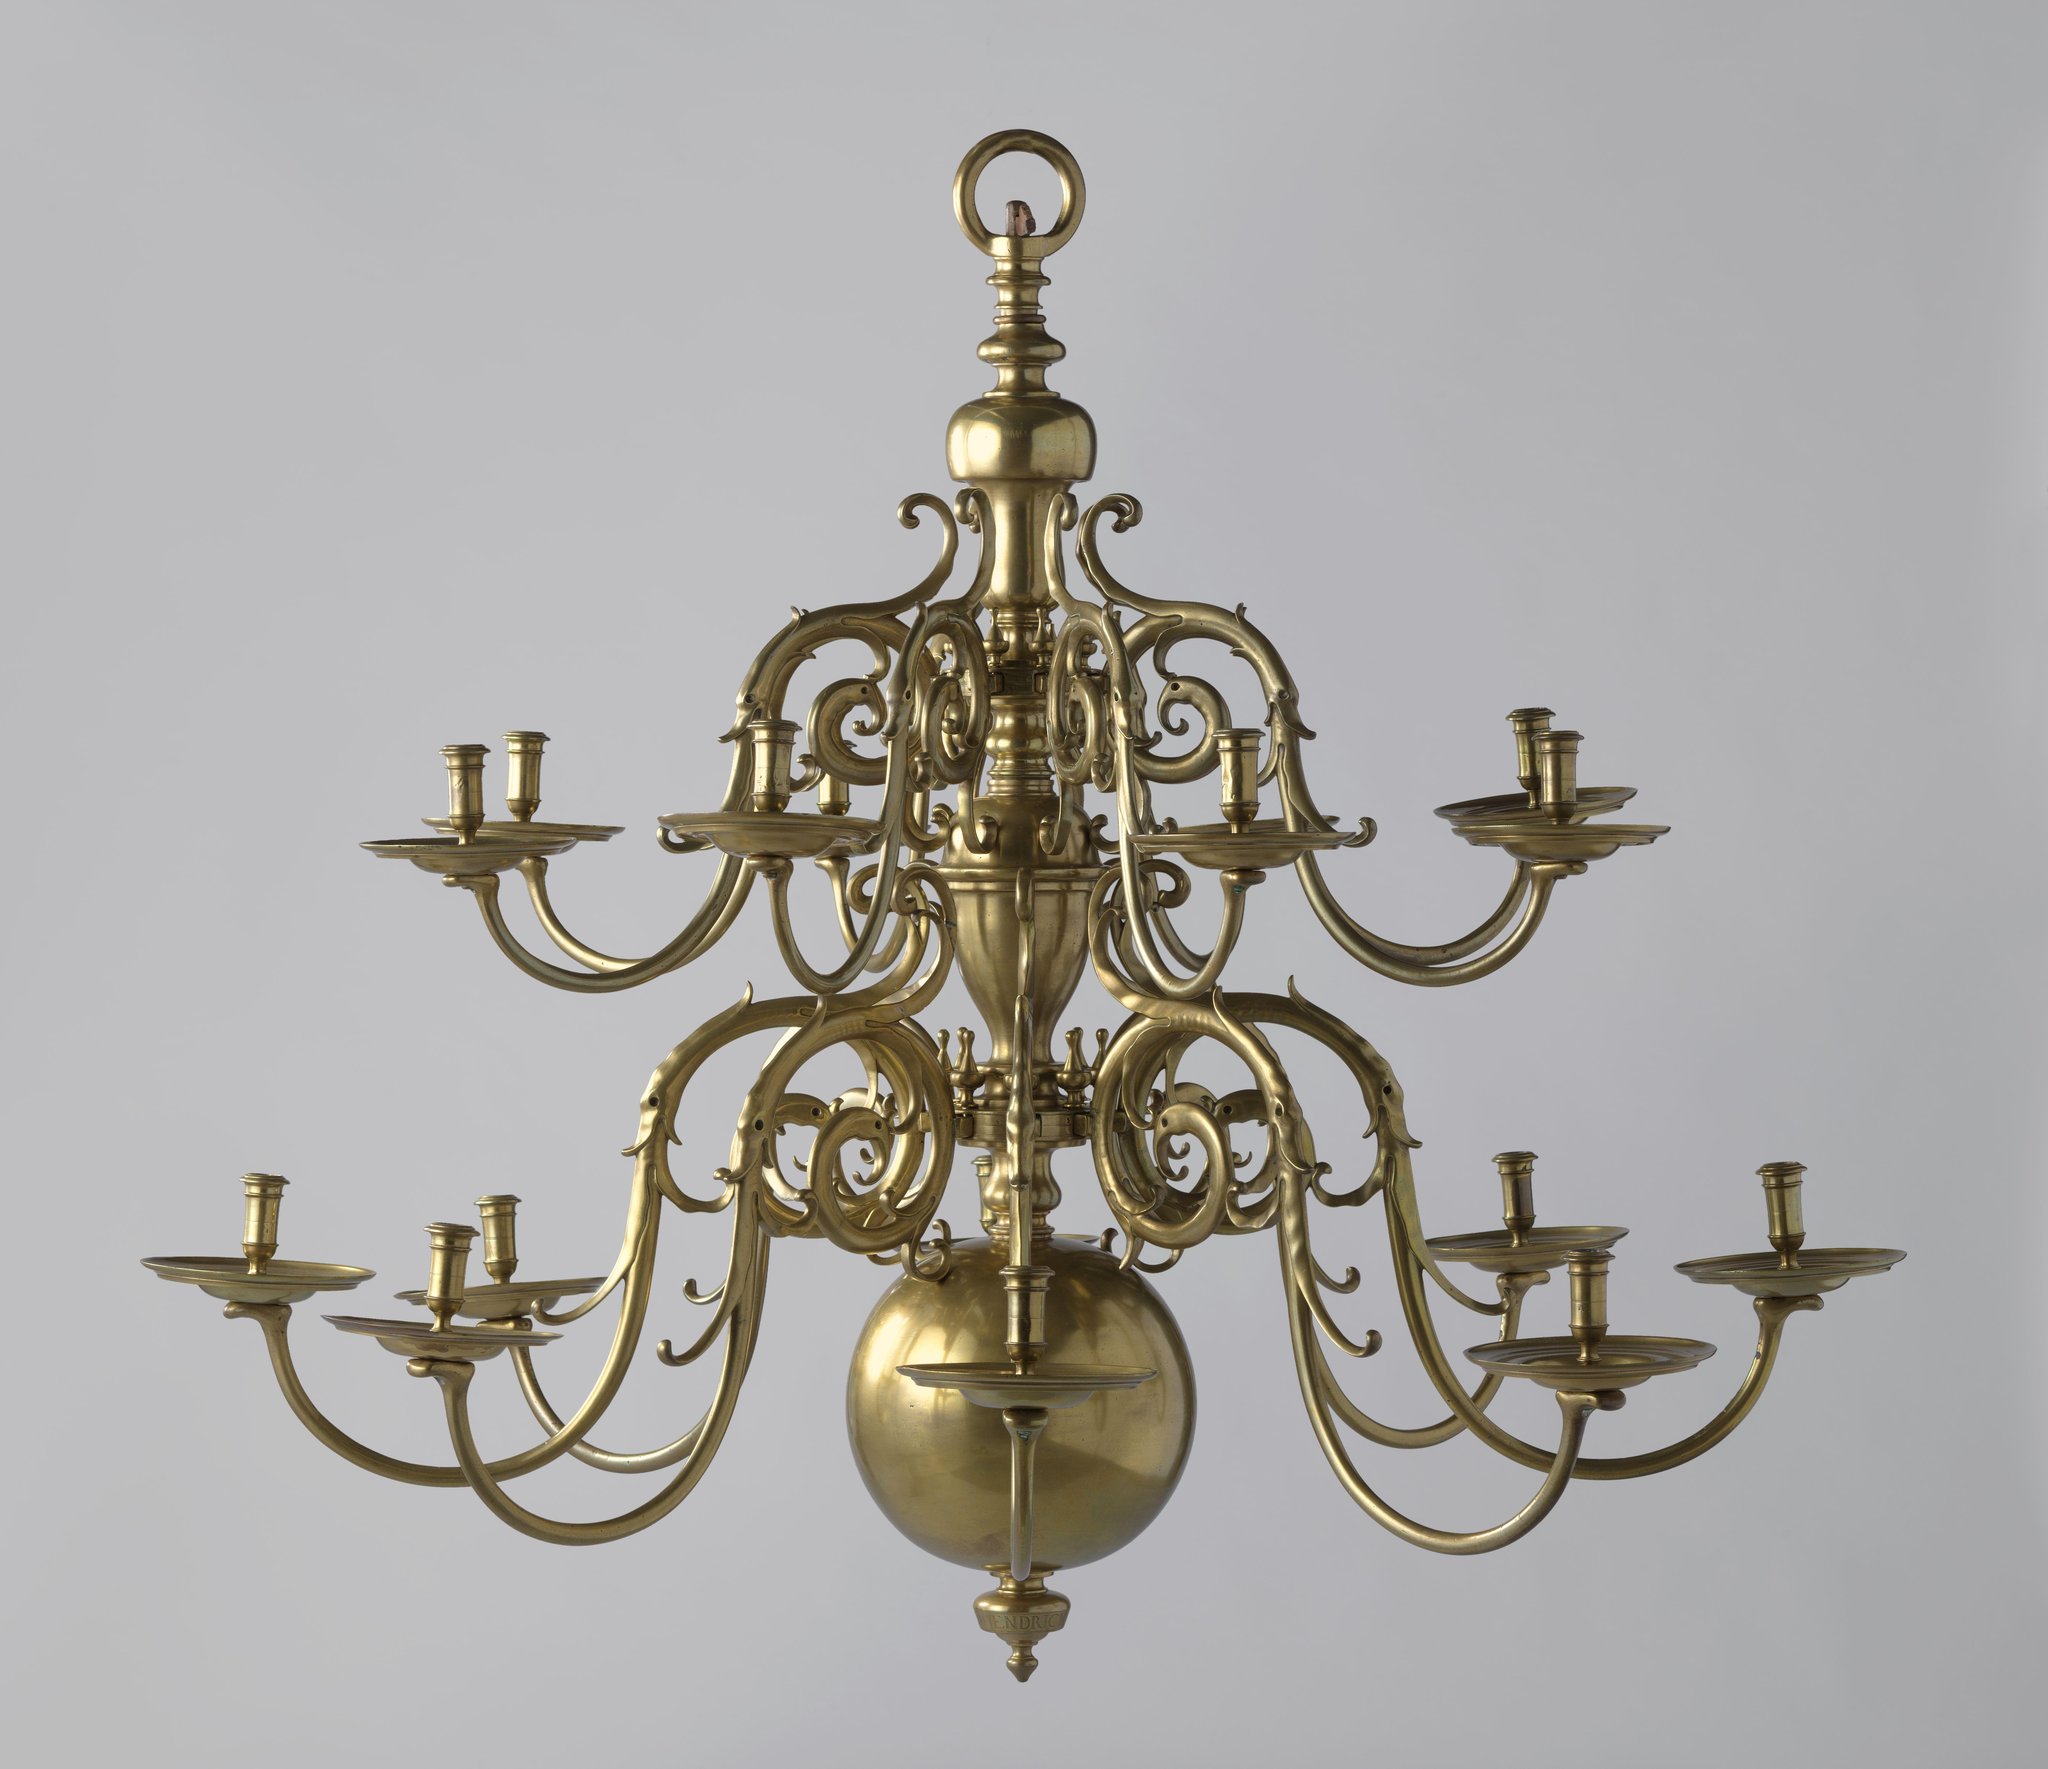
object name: chandelier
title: Arm met kaarsenhouder van kaarsenkroon van twee hoogten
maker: Anonymous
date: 1650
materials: brass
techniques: casting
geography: amsterdam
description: Kaarsenarm behorende bij een messing kaarsenkroon van twee hoogten. De S-vormige arm heeft een krul bij de aanzet, halverwege een dolfijnenkop en gaat naar buiten toe over in het platte verdikking met een schroefgat. Daarin is de kaarsenhouder met de vetvanger vastgezet. De vetvanger is aan de onderzijde geribd geprofileerd rond de opening en heeft een naar onder en een iets uitstekend randje. De cylindrische kaarsenhouder heeft een geprofileerde en een uitstekende rand, twee gegroefde ringen, een rib en een geprofileerd smaller onderstuk, dat overgaat in een uitsteeksel met een schroefdraad met een centergat. De pin om de arm te bevestigen is kegelvormig met een ronde knop bovenop. De vetvanger heeft een dichtgemaakt, rond gat, dat er op wijst dat de kaarsenkroon ooit geëlectrifieerd is geweest. Dit is de eerste arm van de bovenste standring, genummerd met het cijfer 5.